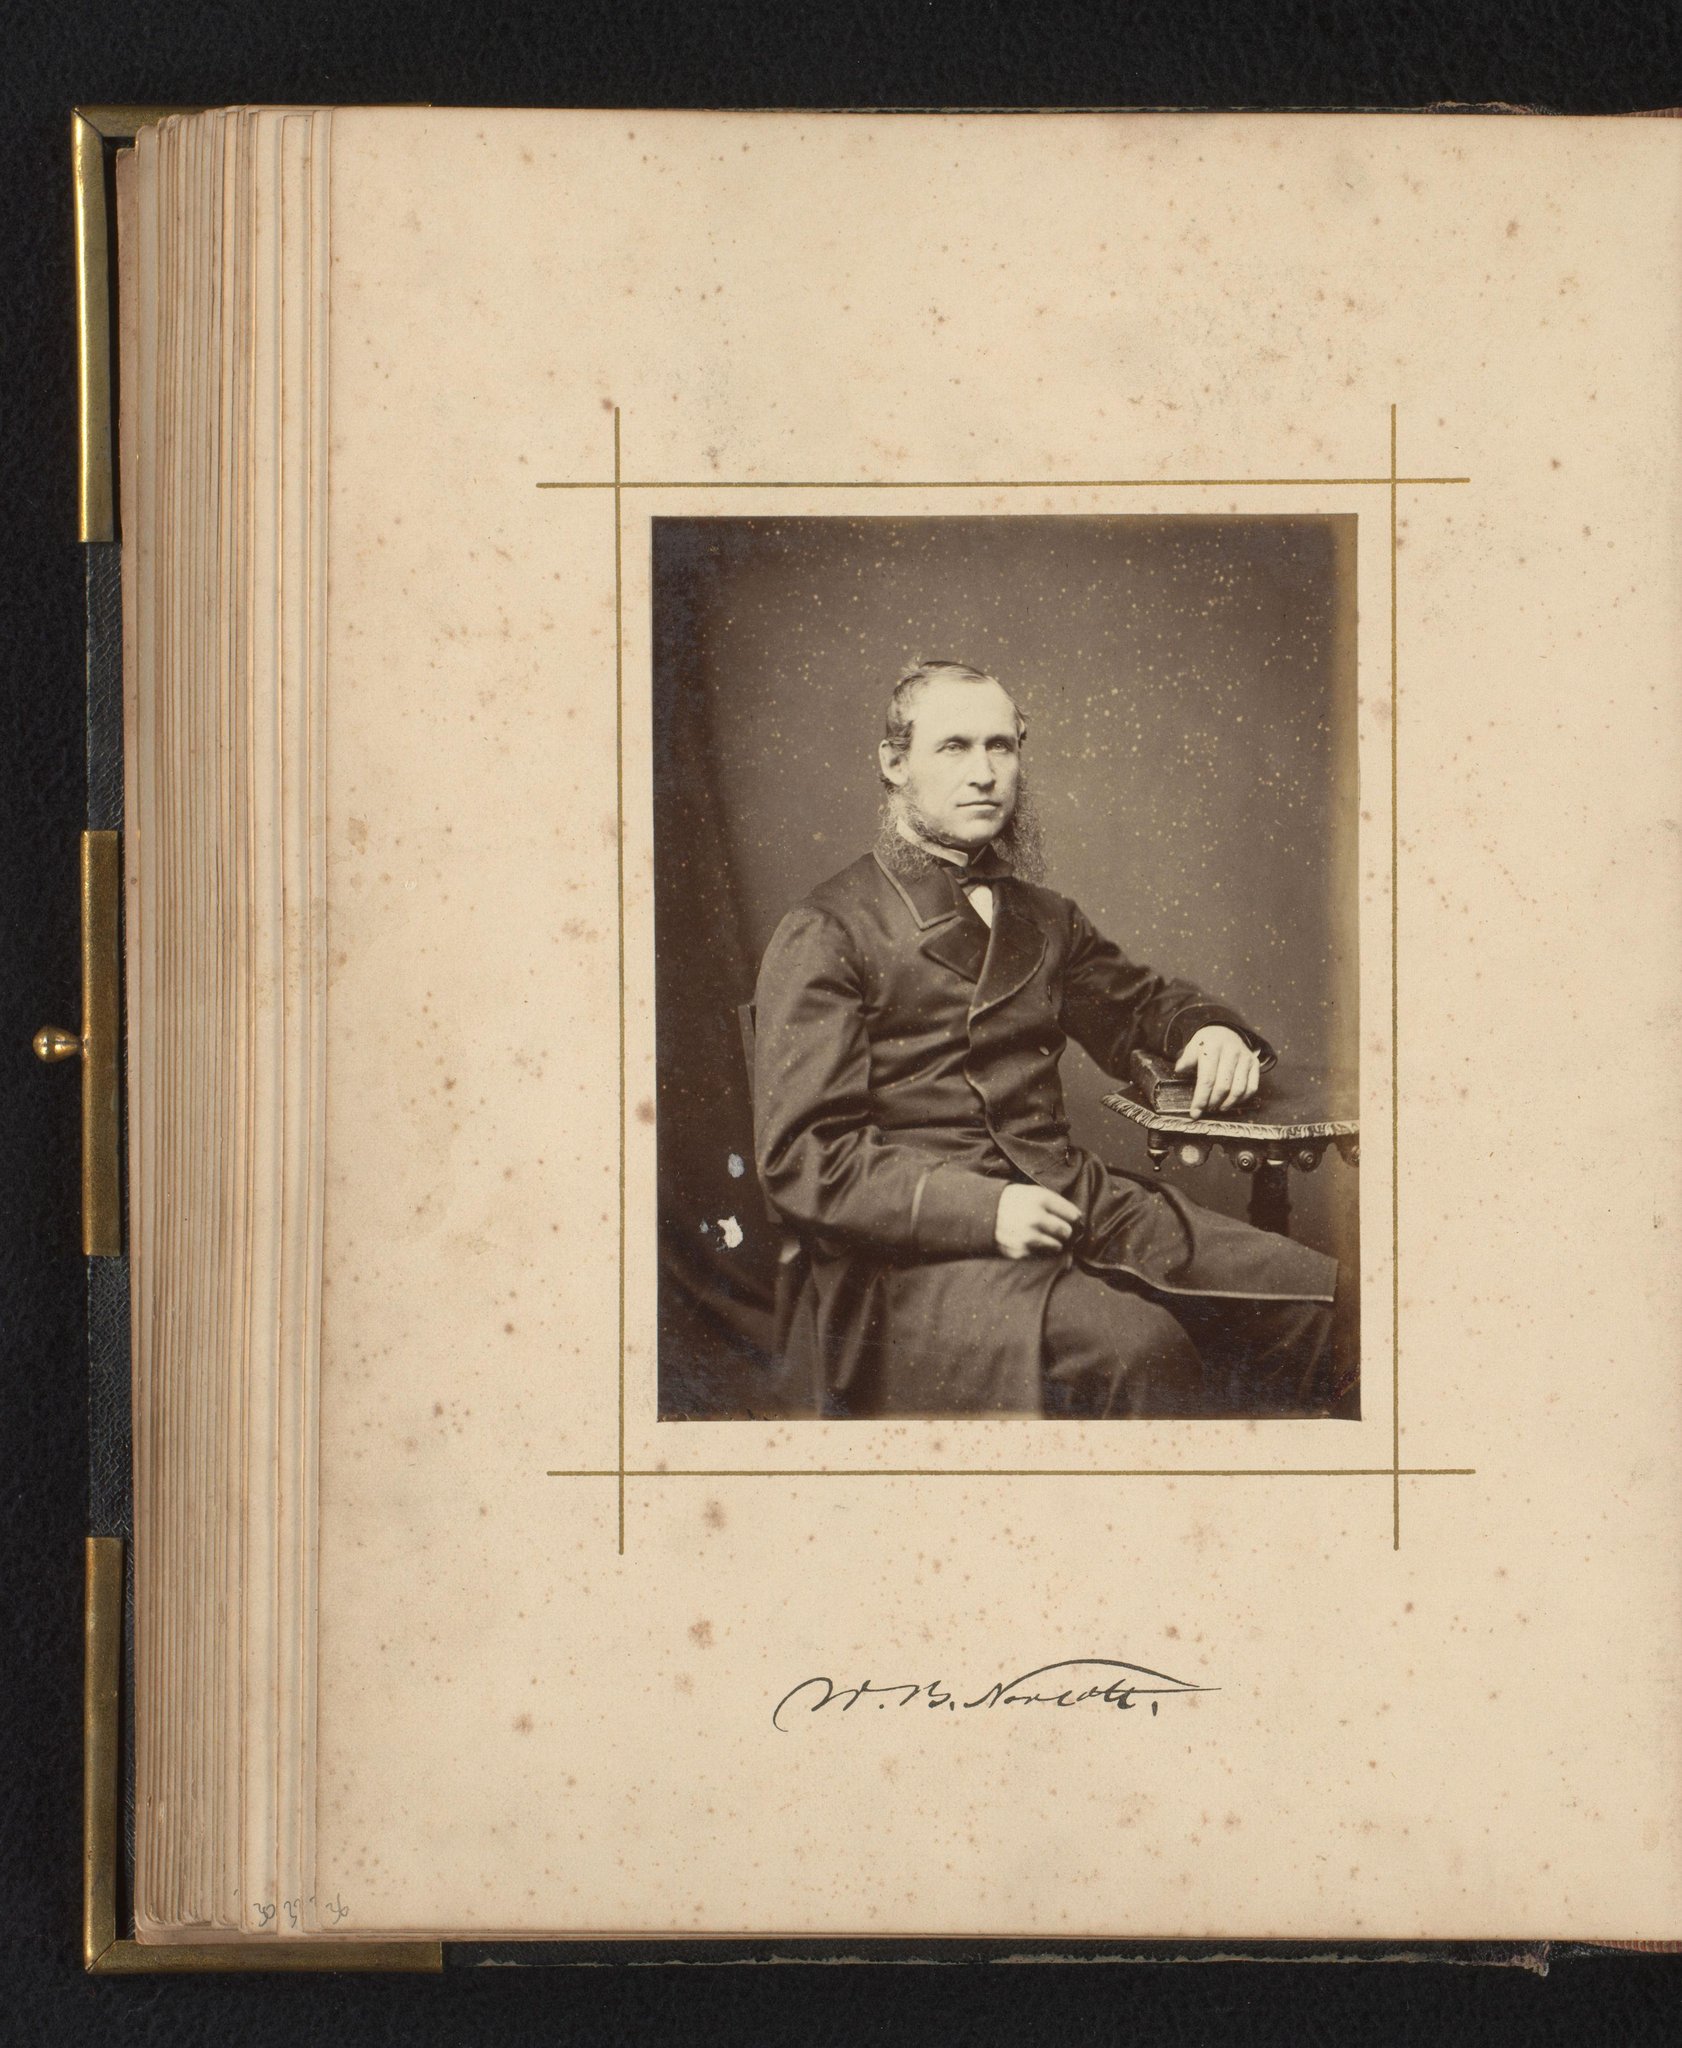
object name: page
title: Portret van een man, mogelijk W.B. Norcott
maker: Anonymous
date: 1866-1871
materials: photographic support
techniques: albumen print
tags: sitting figure, historical persons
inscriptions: name: ‘[W.B. Norcott]’